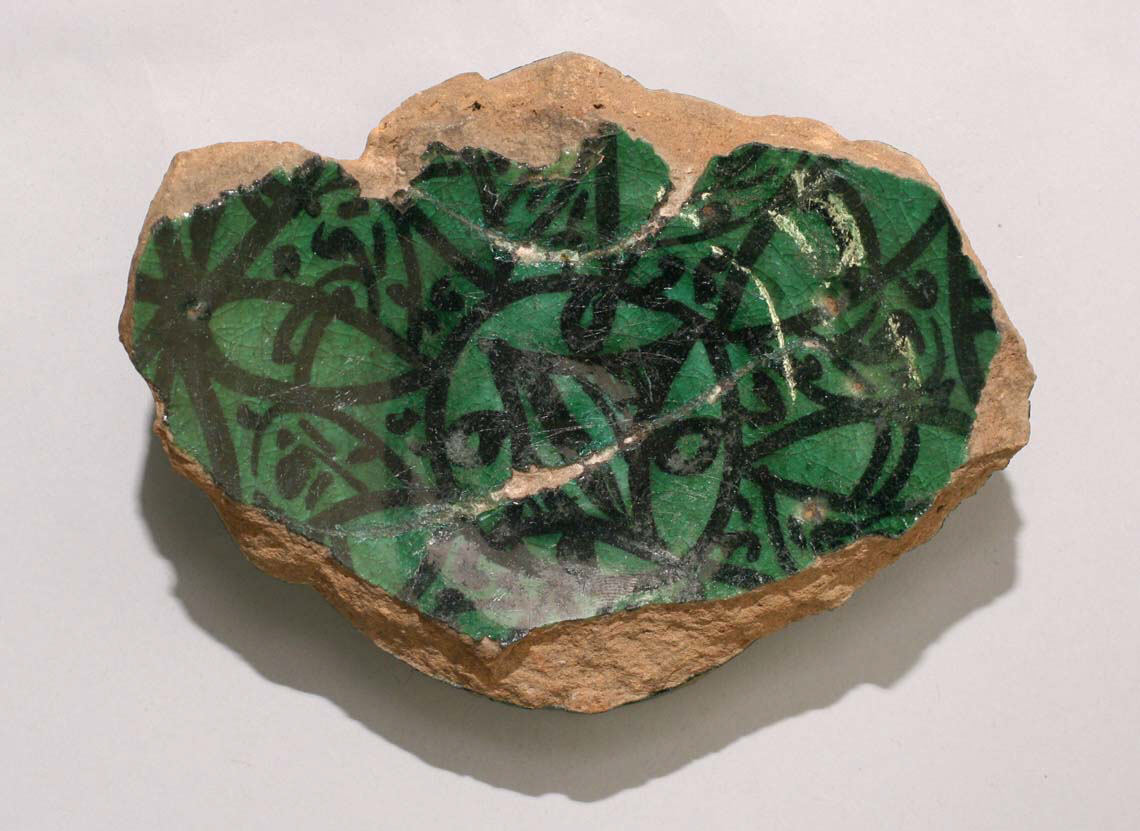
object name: ceramic fragment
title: Fragment of a Bowl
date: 1301-1500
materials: glaze, stonepaste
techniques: painting, underglaze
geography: egypt